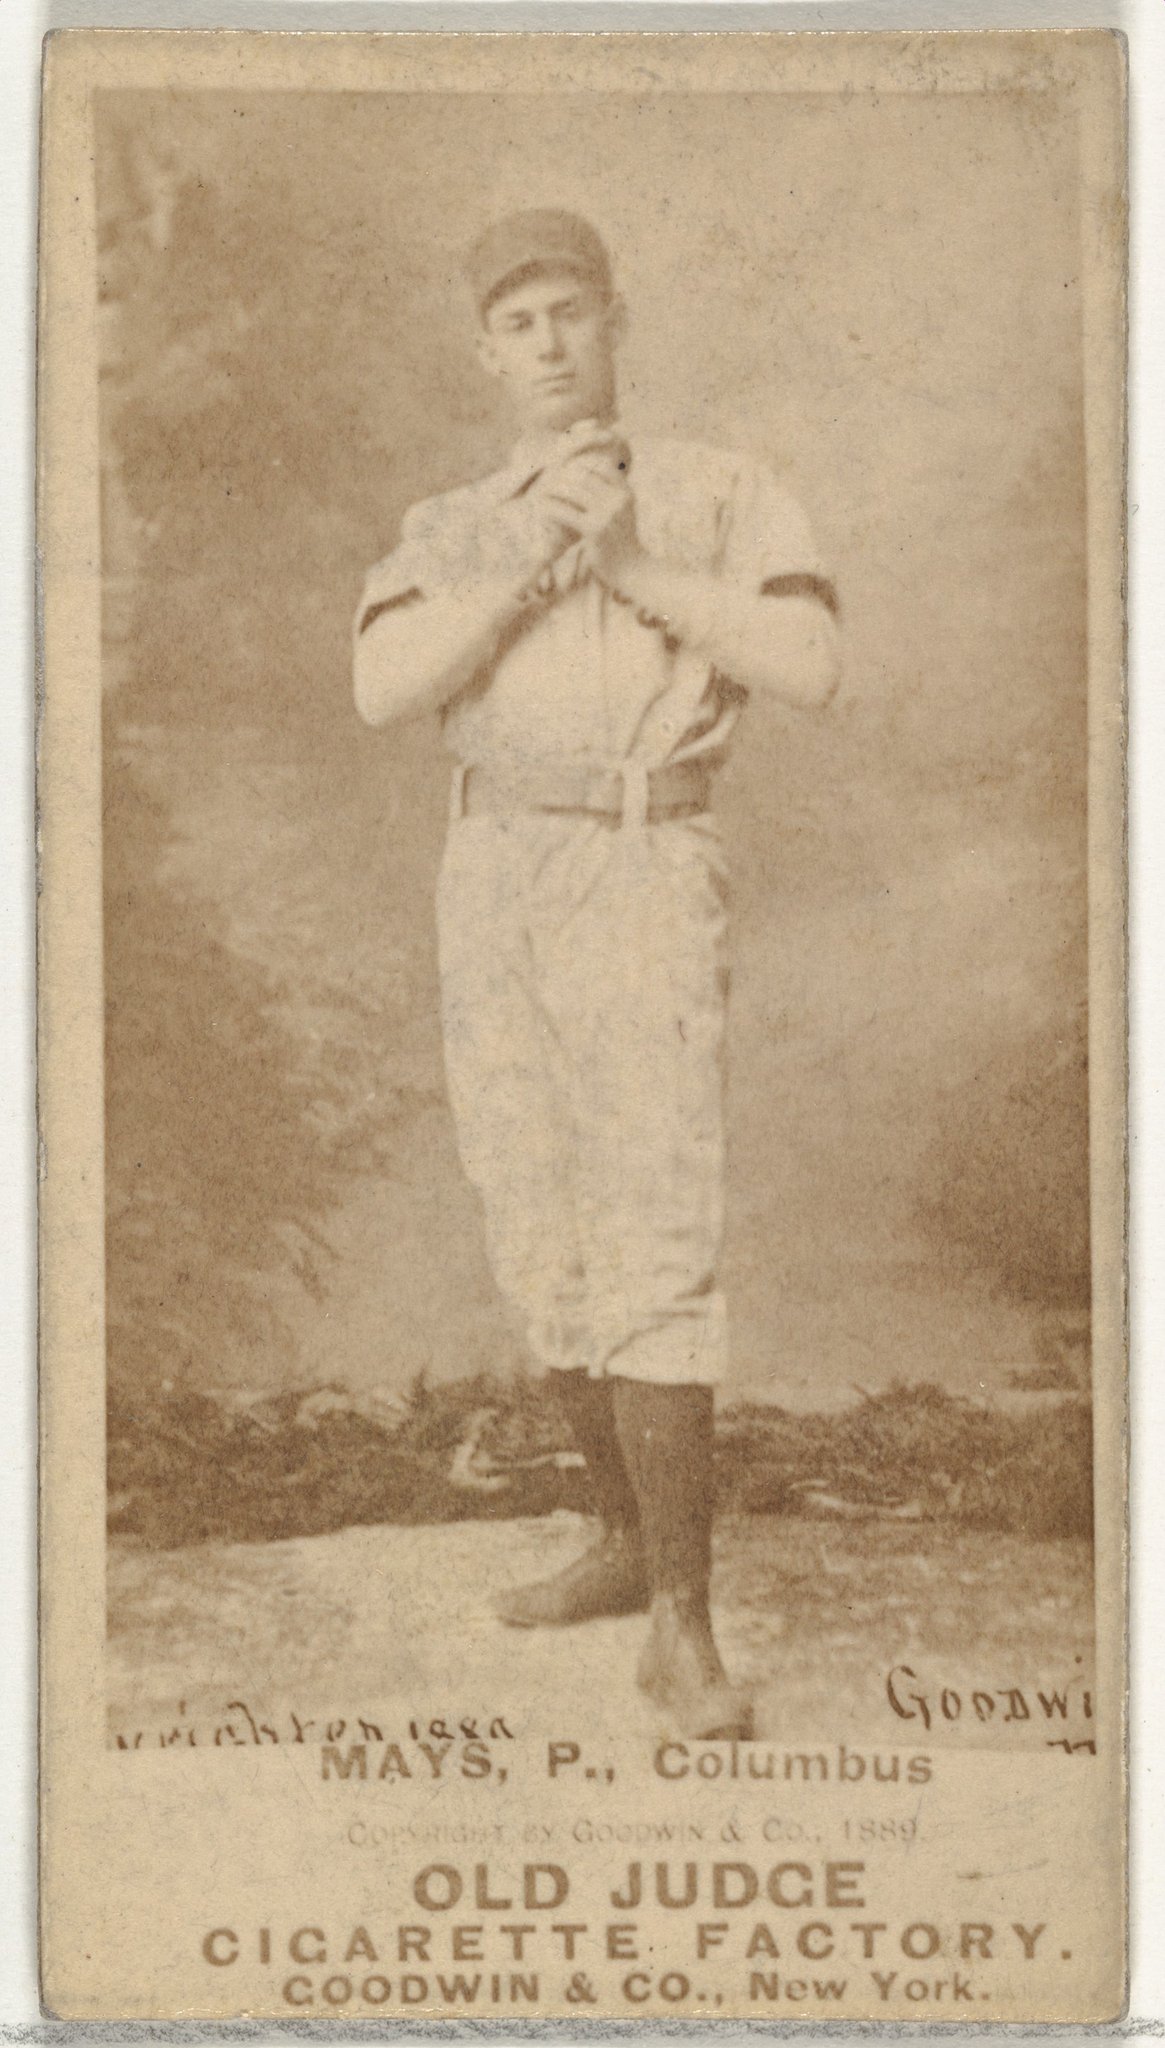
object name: baseball card, photograph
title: Albert C. "Al" Mays, Pitcher, Cleveland, from the Old Judge series (N172) for Old Judge Cigarettes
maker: goodwin & company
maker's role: publisher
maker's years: 1850-1950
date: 1889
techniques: albumen silver print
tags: men,portraits,baseball,athletes